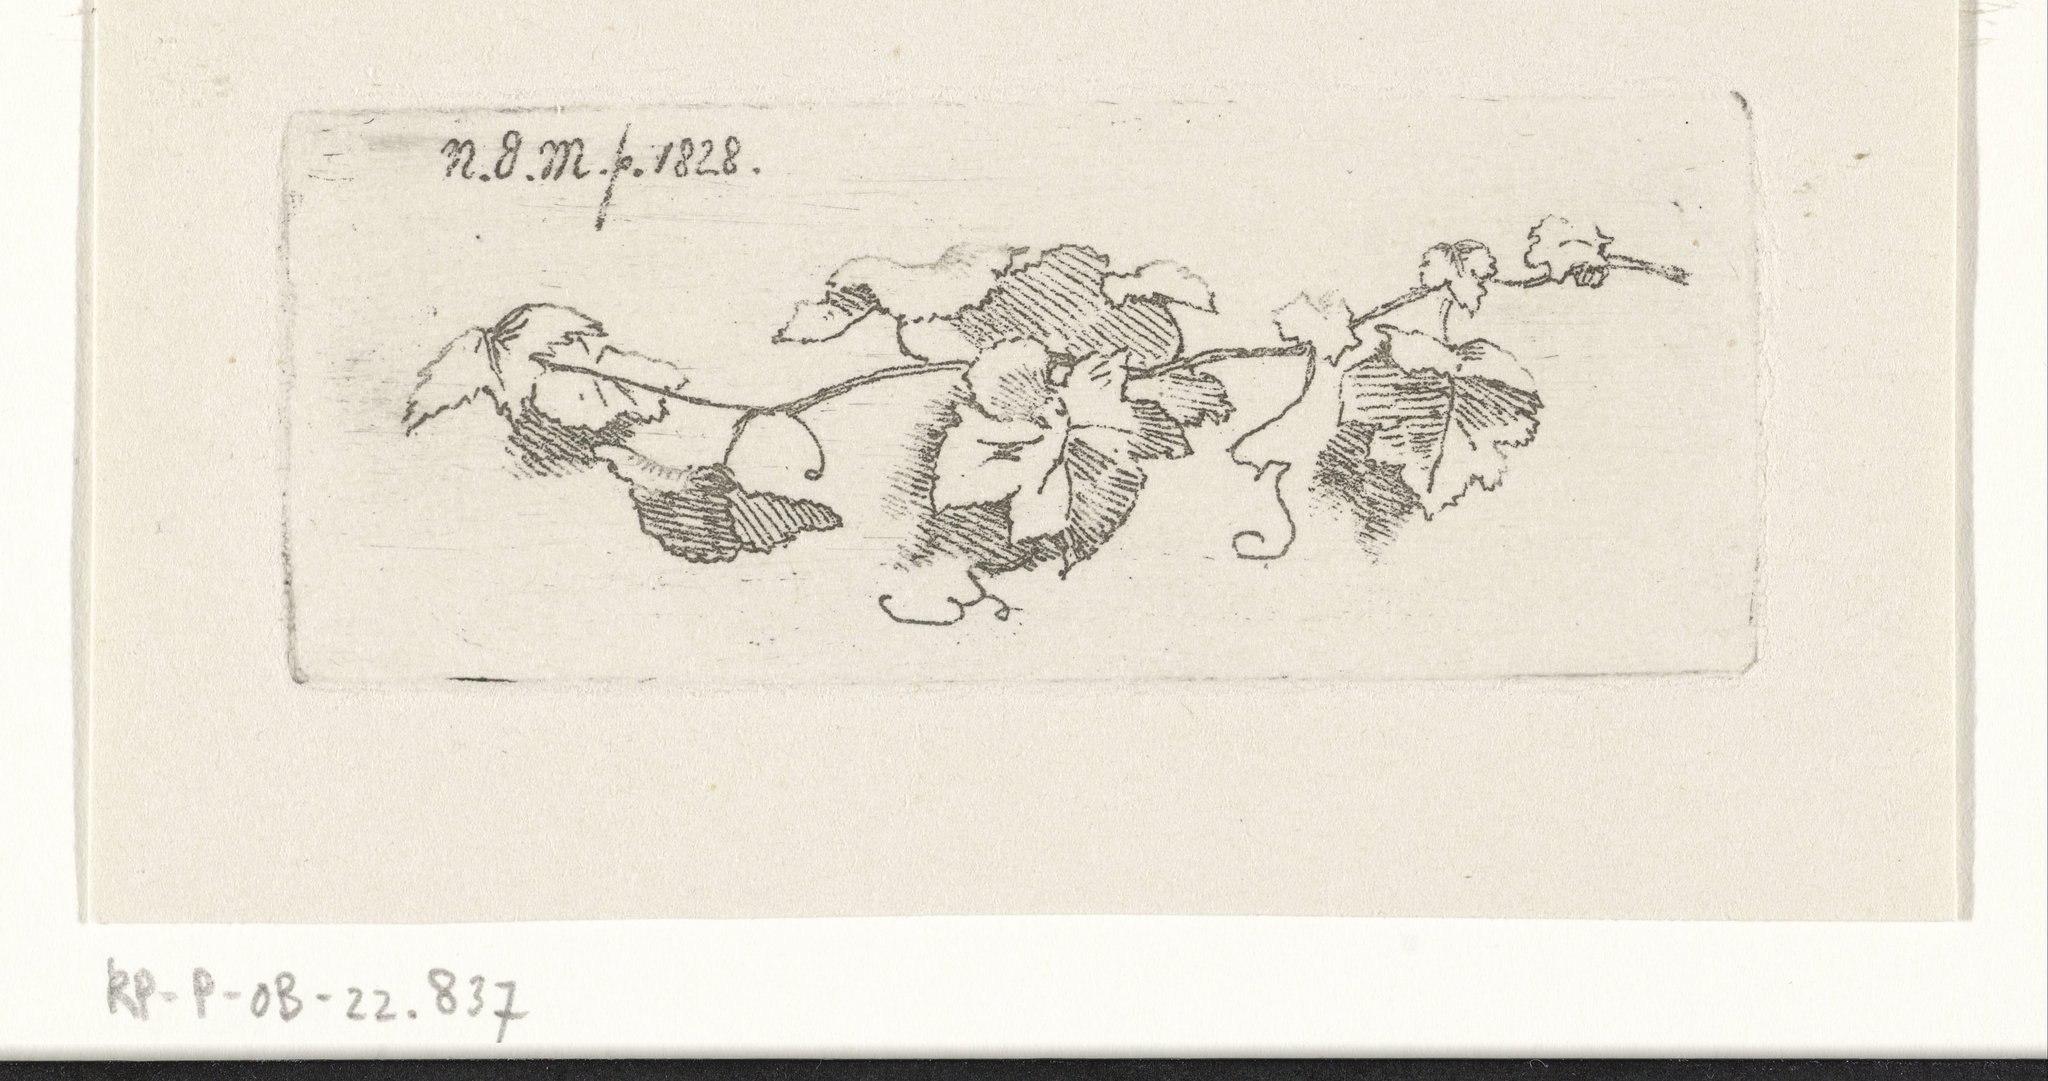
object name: print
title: Wingerd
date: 1828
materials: paper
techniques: etching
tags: plants (in general)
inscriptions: collector's mark: Lugt 2228